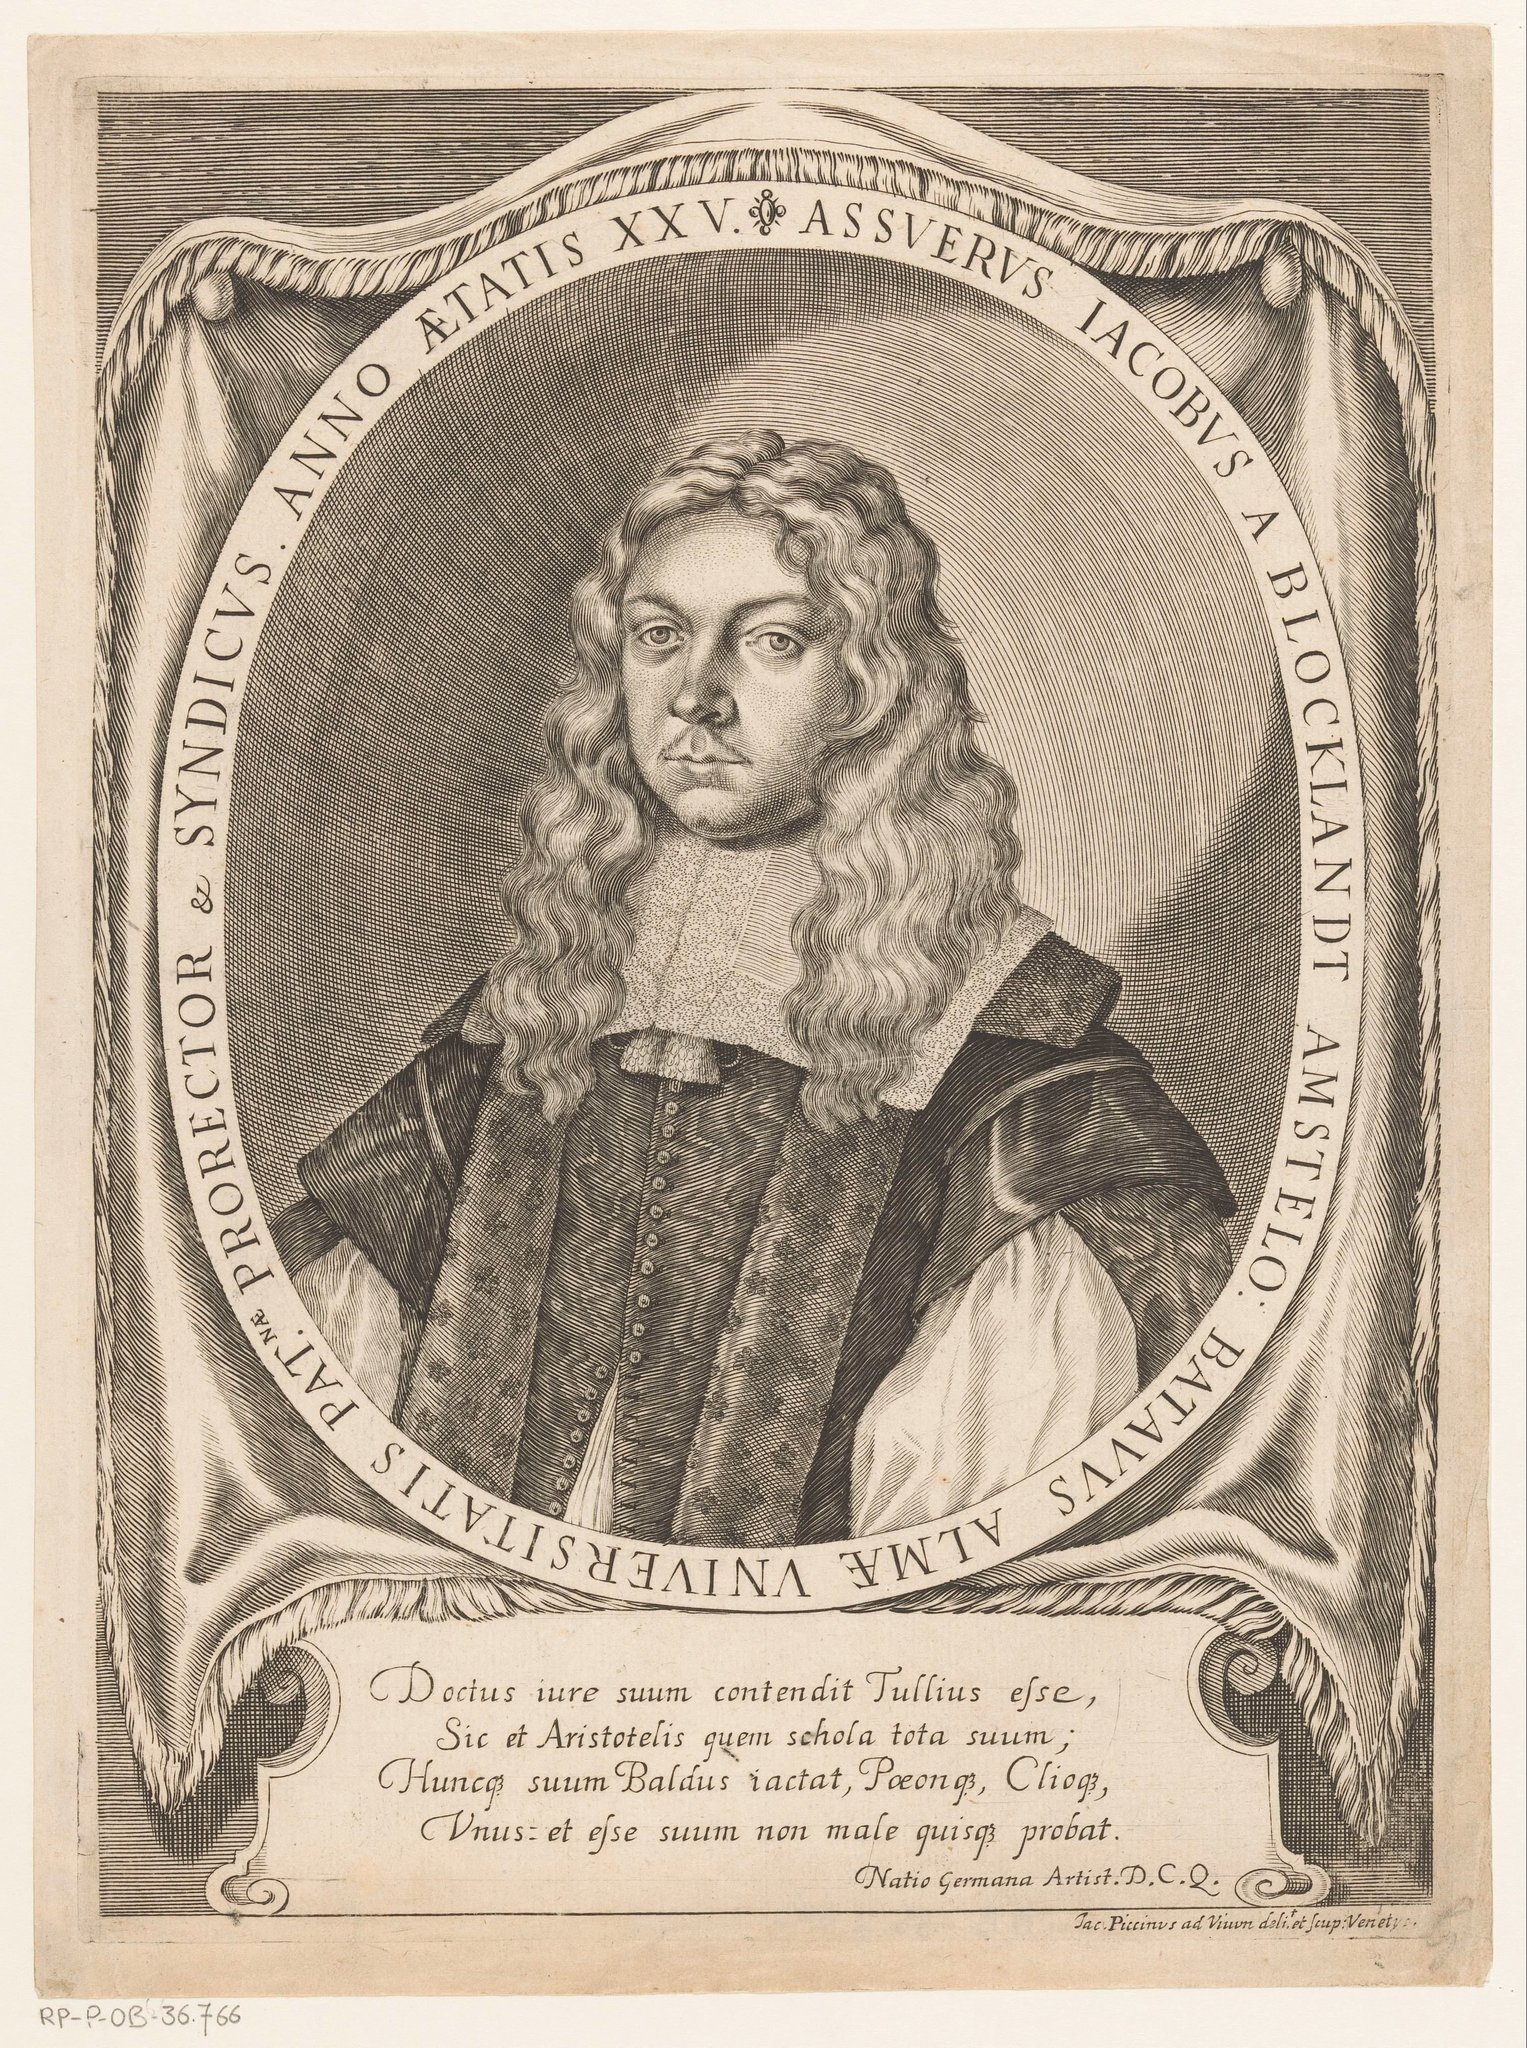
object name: print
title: Portret van academicus Assuerusz. Jacob van Blocklandt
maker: giacomo piccini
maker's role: print maker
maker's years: 1617-1669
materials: paper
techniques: engraving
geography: venice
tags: historical persons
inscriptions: collector's mark: Lugt 2228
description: Portret in een ovaal met daaronder een cartouche met vier regels tekst in het Latijn.